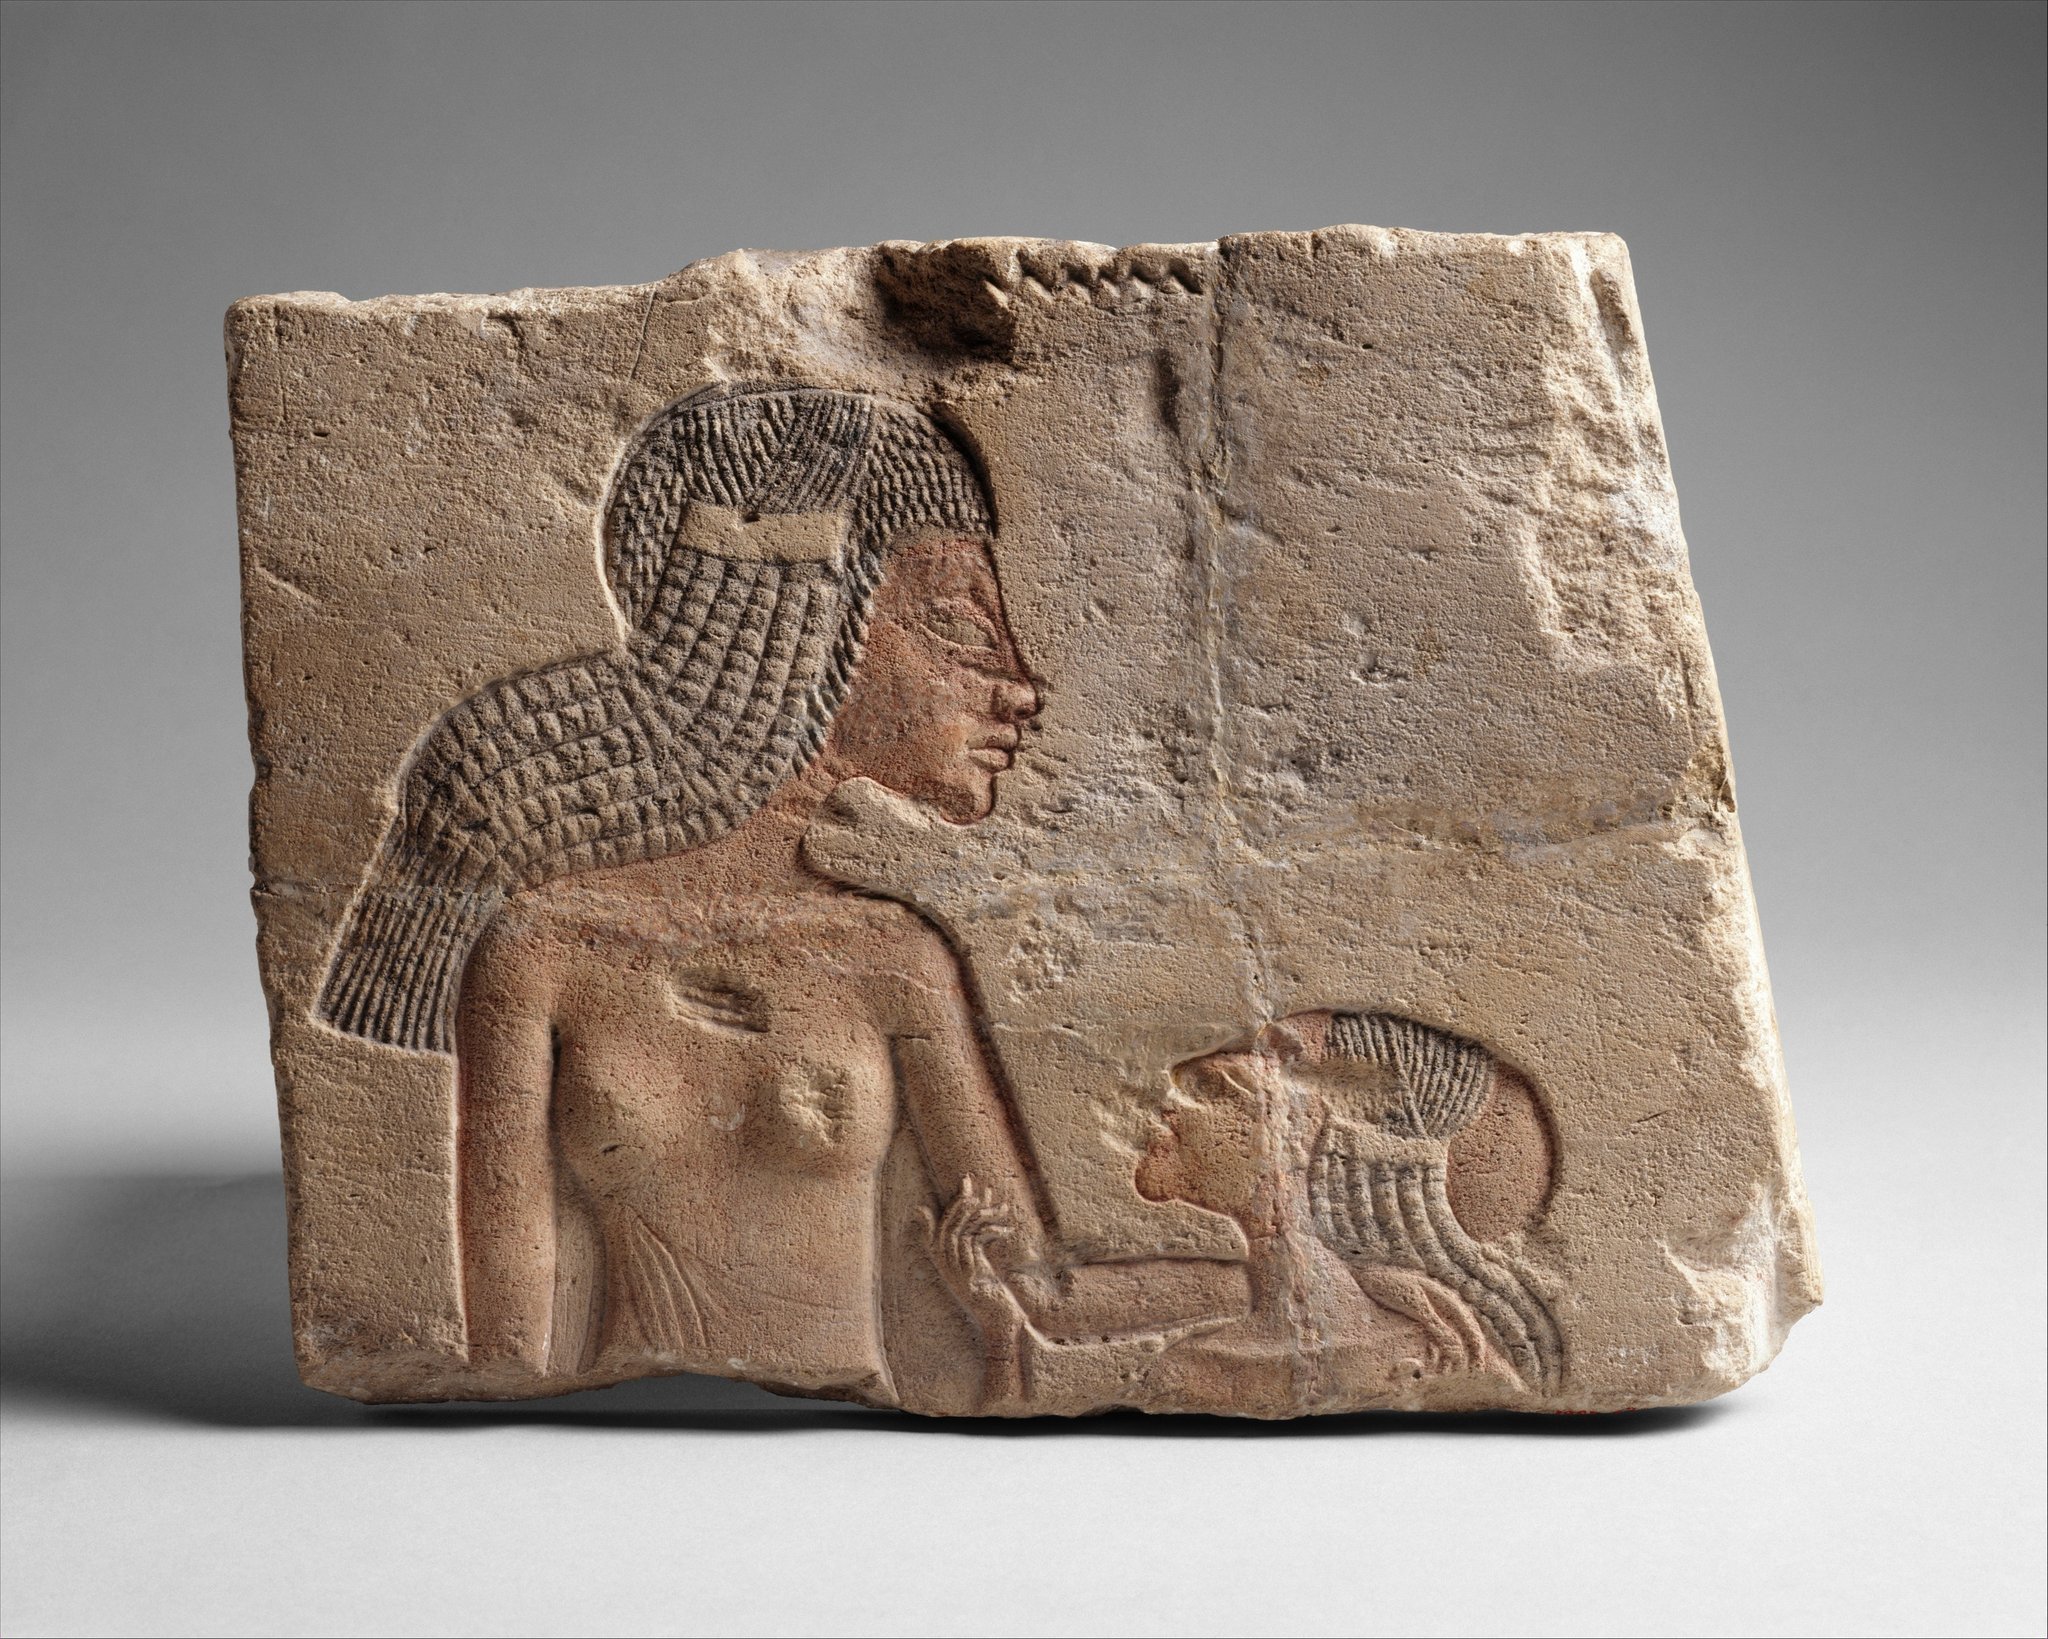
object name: two princess, daughter of akhenaten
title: Two Princesses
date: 1353-1336 BCE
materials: limestone, paint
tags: princesses